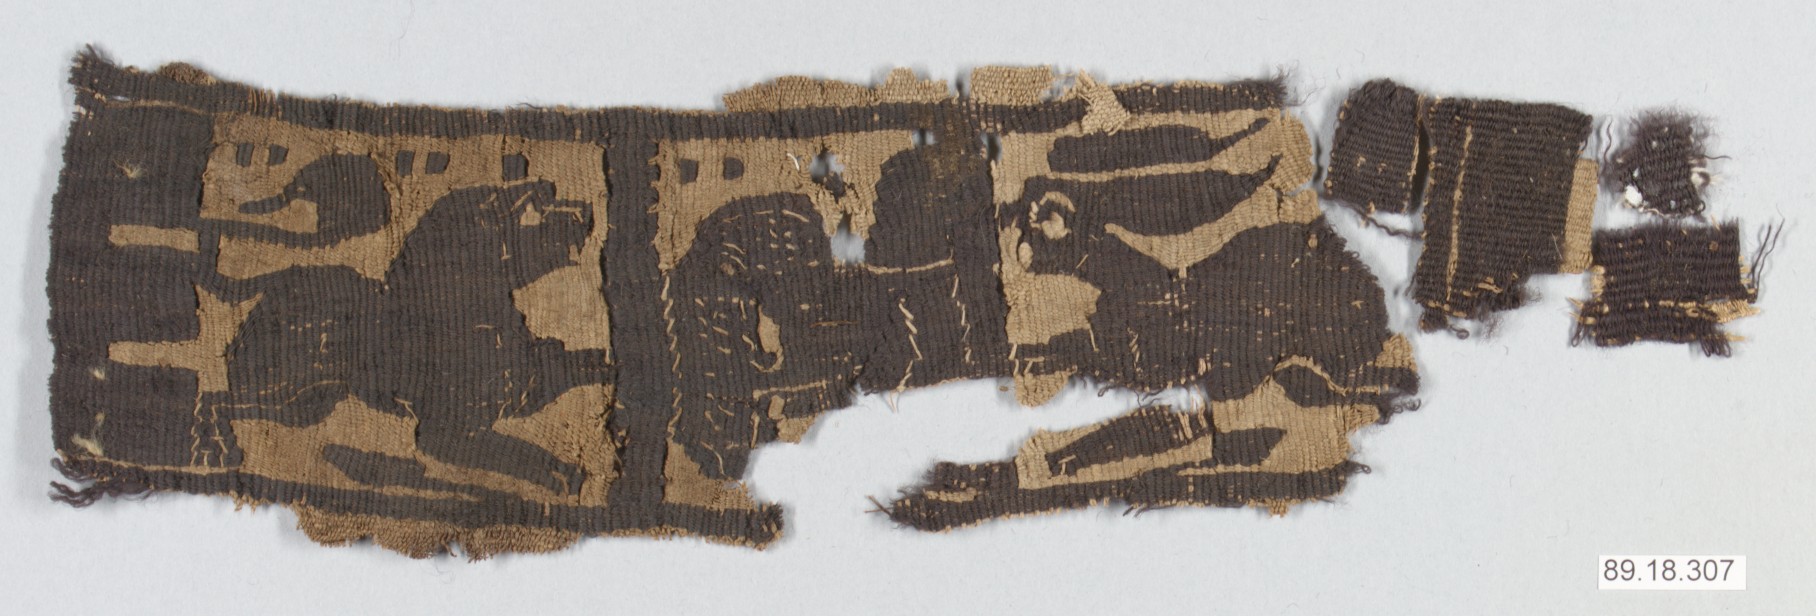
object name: textile fragment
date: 201-400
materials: linen, wool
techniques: weave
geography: egypt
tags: animals